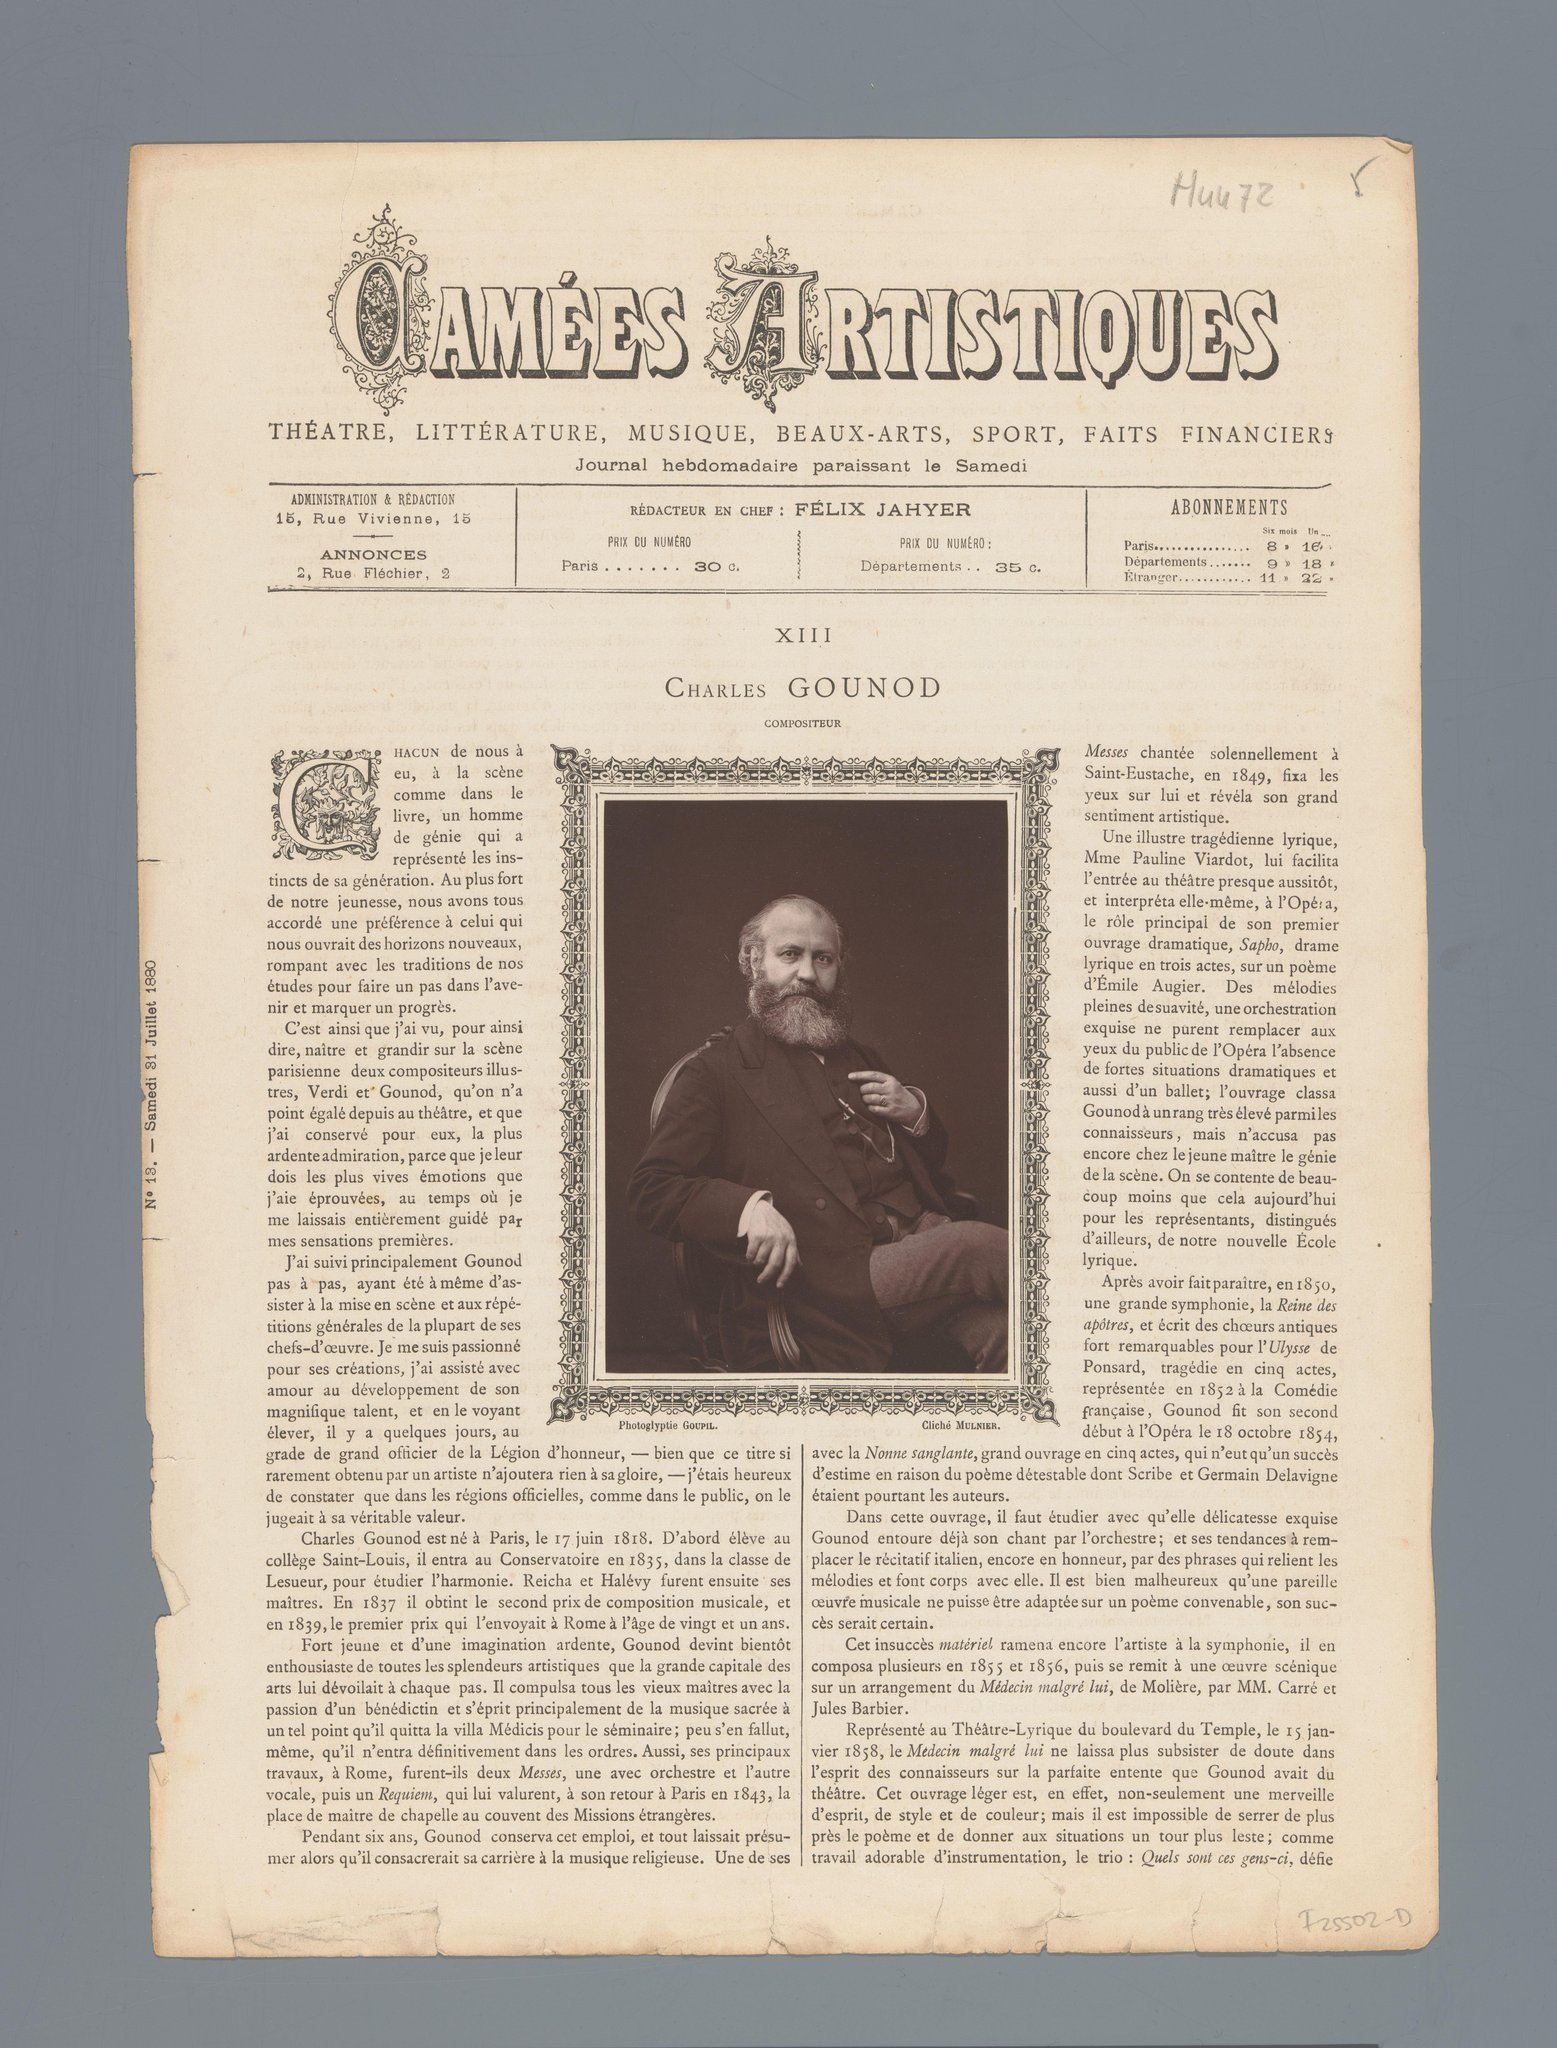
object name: photomechanical print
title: Charles Gounod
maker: ferdinand mulnier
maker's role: painter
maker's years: 1817-1891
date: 1876-1883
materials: paper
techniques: woodburytype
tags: charles gounod, historical persons, portrait of composer